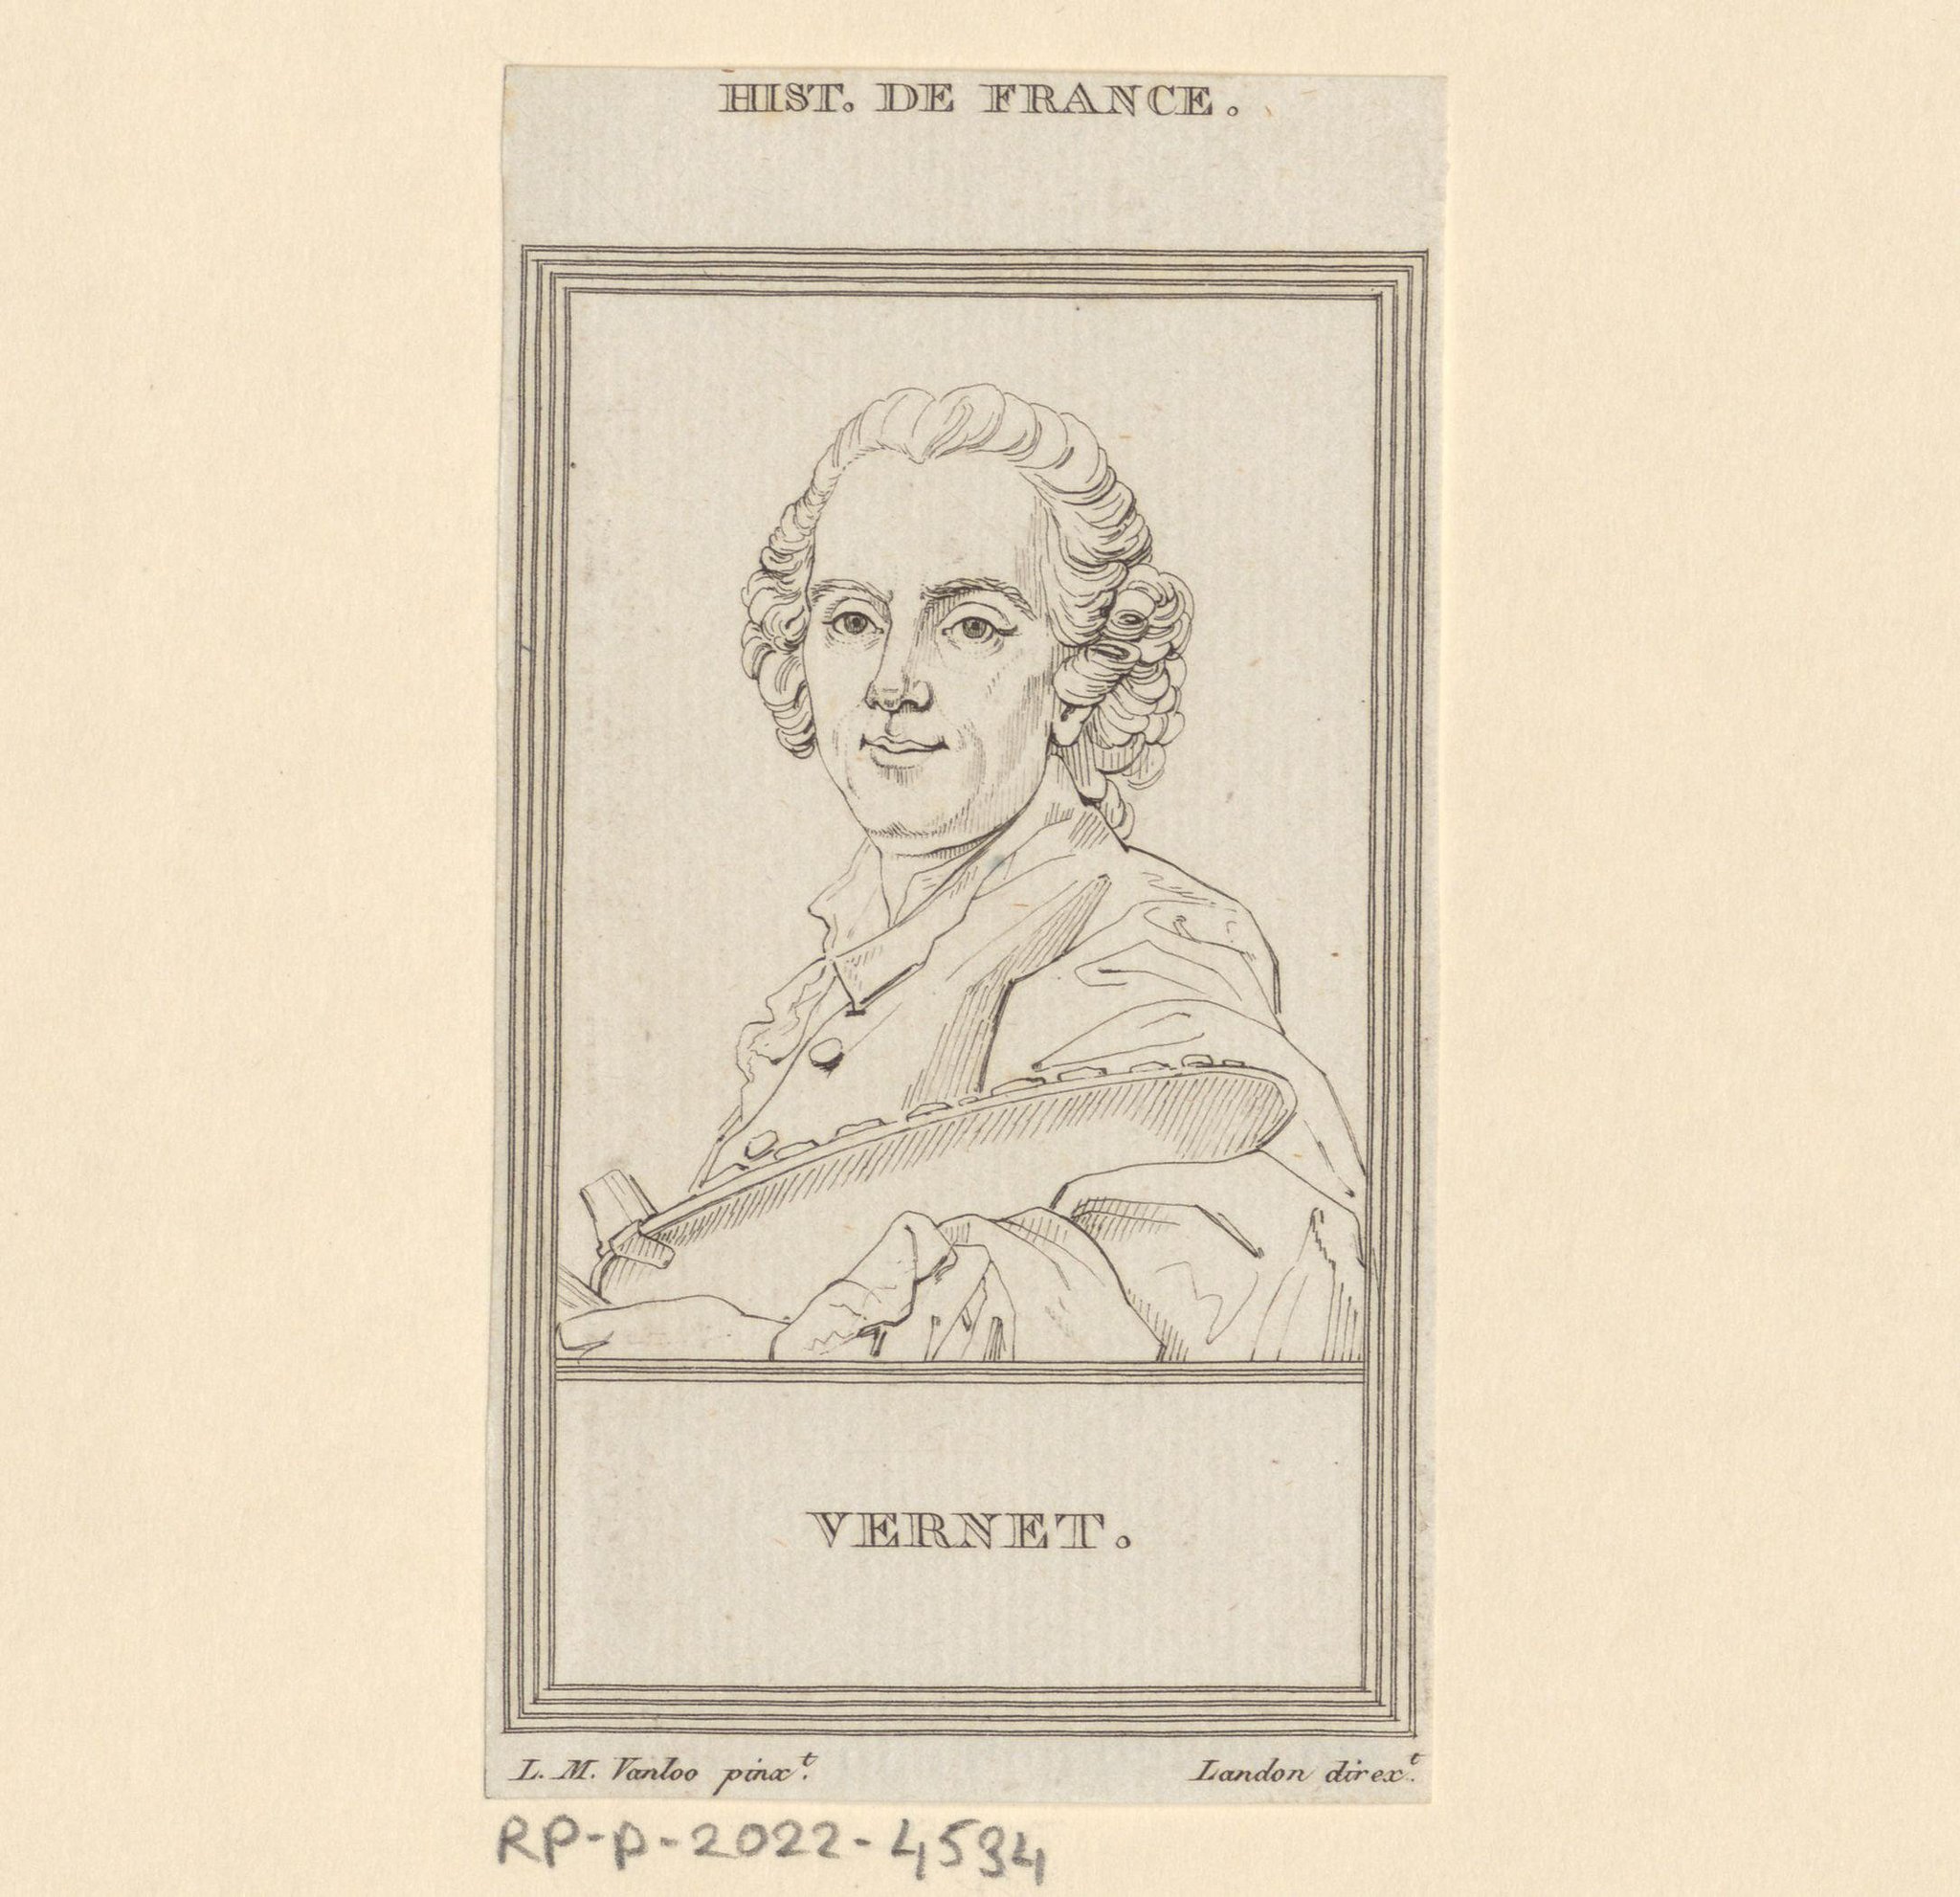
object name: print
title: Portret van Claude Joseph Vernet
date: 1805-1811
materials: paper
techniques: etching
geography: france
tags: paris, painter, print maker, draughtsman, claude joseph vernet, historical persons, portrait, self-portrait of painter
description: Prent waarschijnlijk uit een deel van: Galerie historique des hommes les plus célèbres (...). Parijs: Charles Paul Landon, 1805-1811.